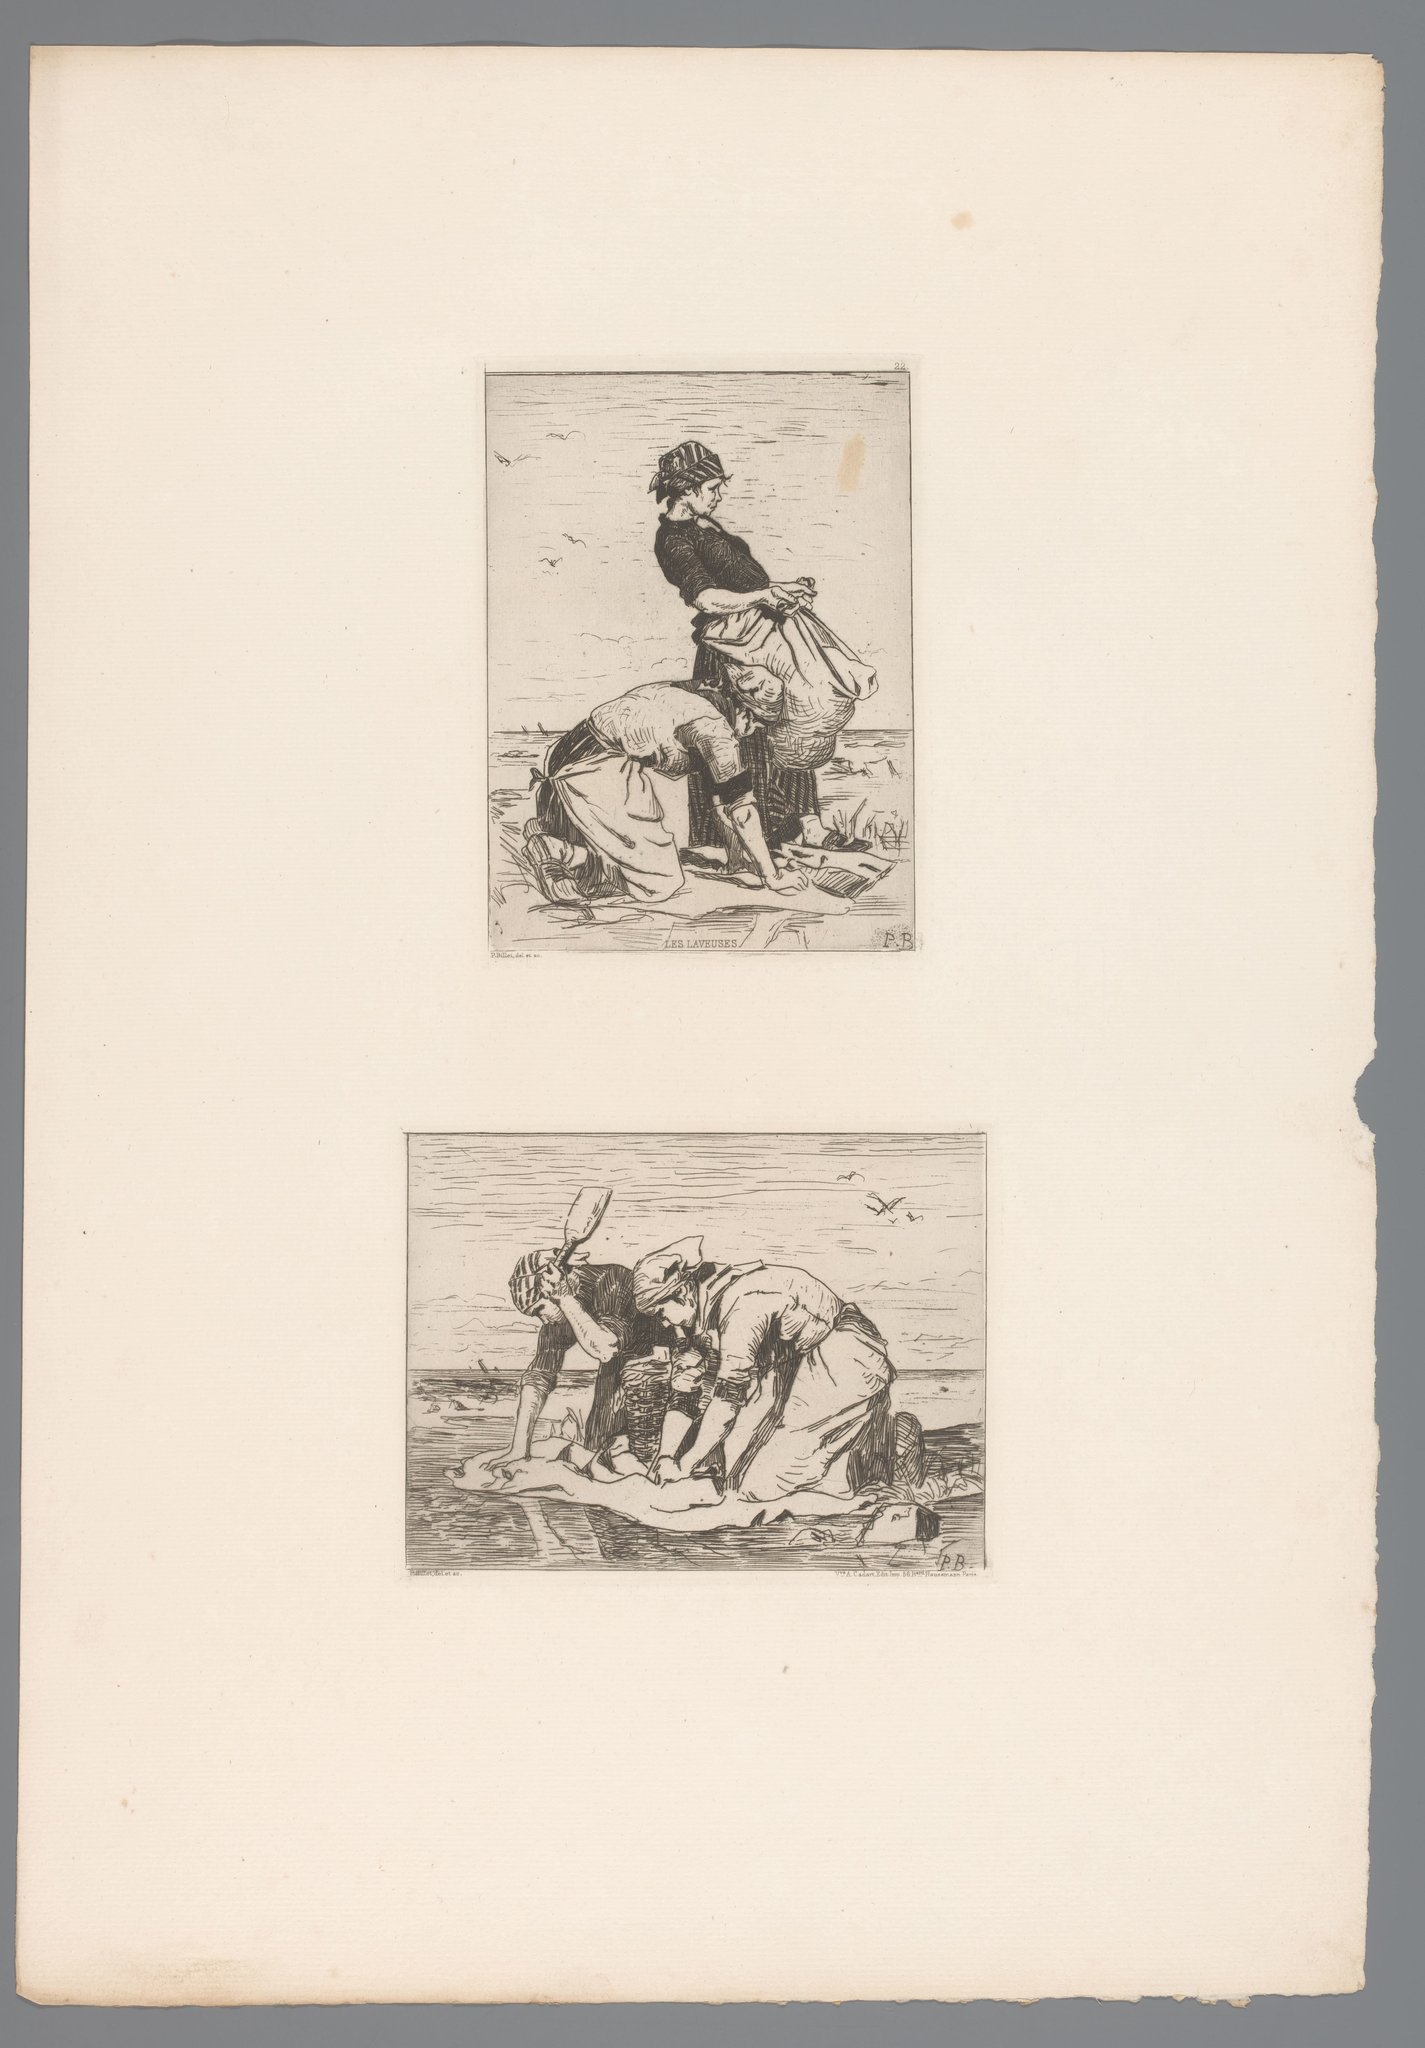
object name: print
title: Twee vrouwen die de was doen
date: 1876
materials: paper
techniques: drypoint, etching, intaglio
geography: paris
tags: laundering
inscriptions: watermark, collector's mark: ‘AFE v S’, collector's mark: Lugt 2228, collector's mark: Lugt 2760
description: Prent op onversneden blad met RP-P-1991-269.